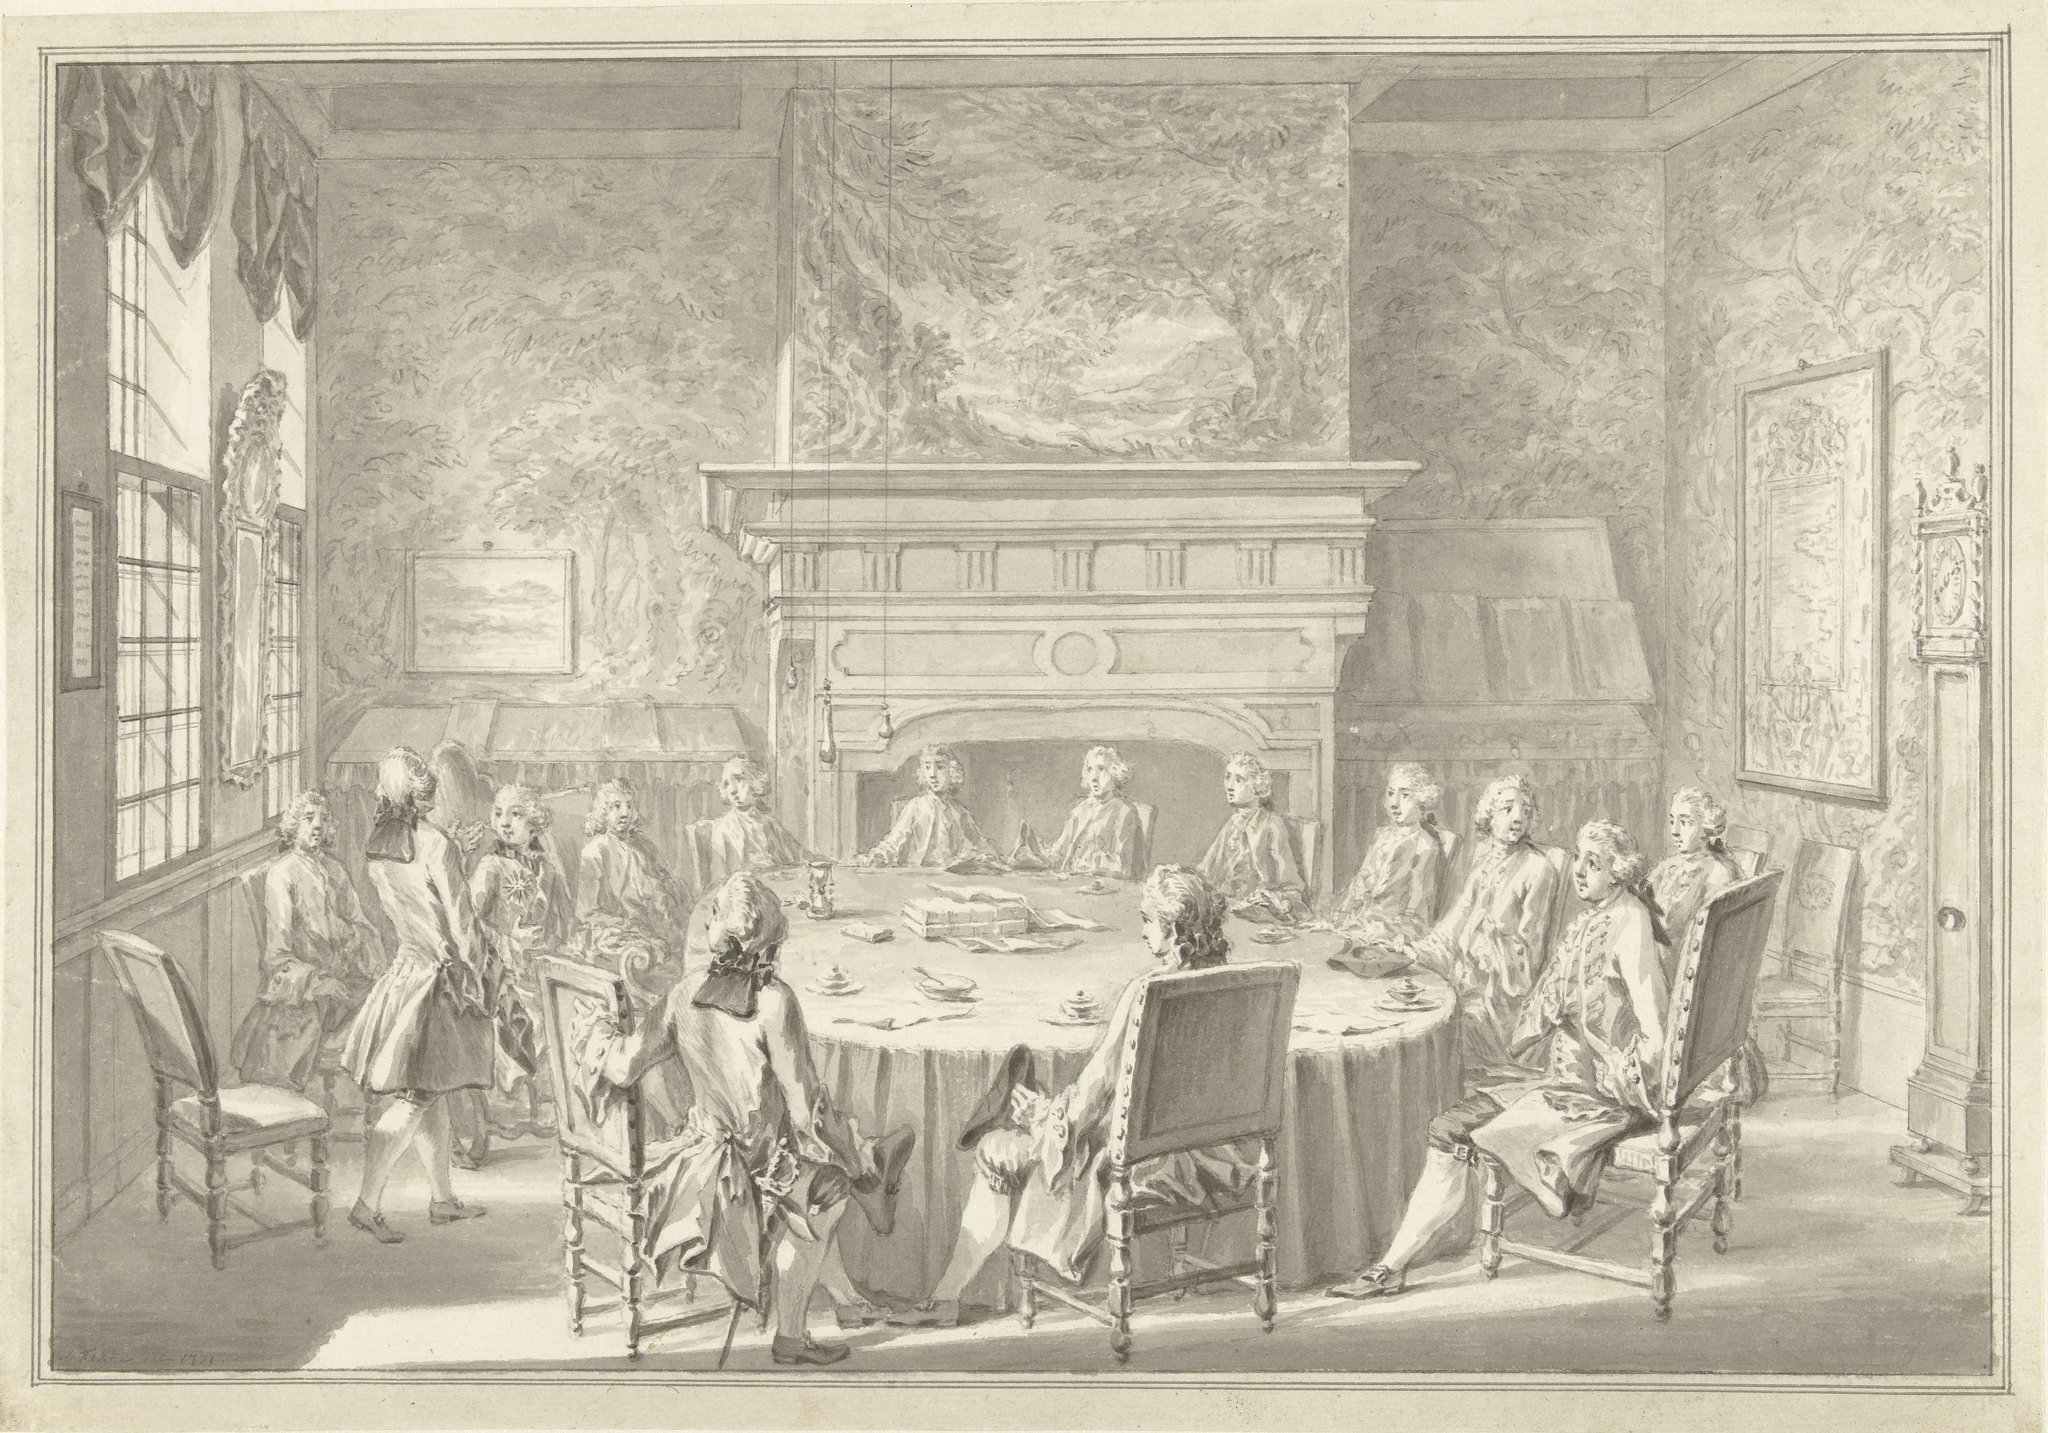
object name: design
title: Zittingneming van Willem V in de W.I.C., bij zijn bezoek aan Amsterdam in 1768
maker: simon fokke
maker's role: draughtsman, print maker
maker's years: 1712-1784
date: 1771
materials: chalk, ink, paper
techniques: brush, pen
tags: the hague, william v (prince of orange), historical persons, names of organizations, companies, trade unions, etc., historical events and situations, amsterdam